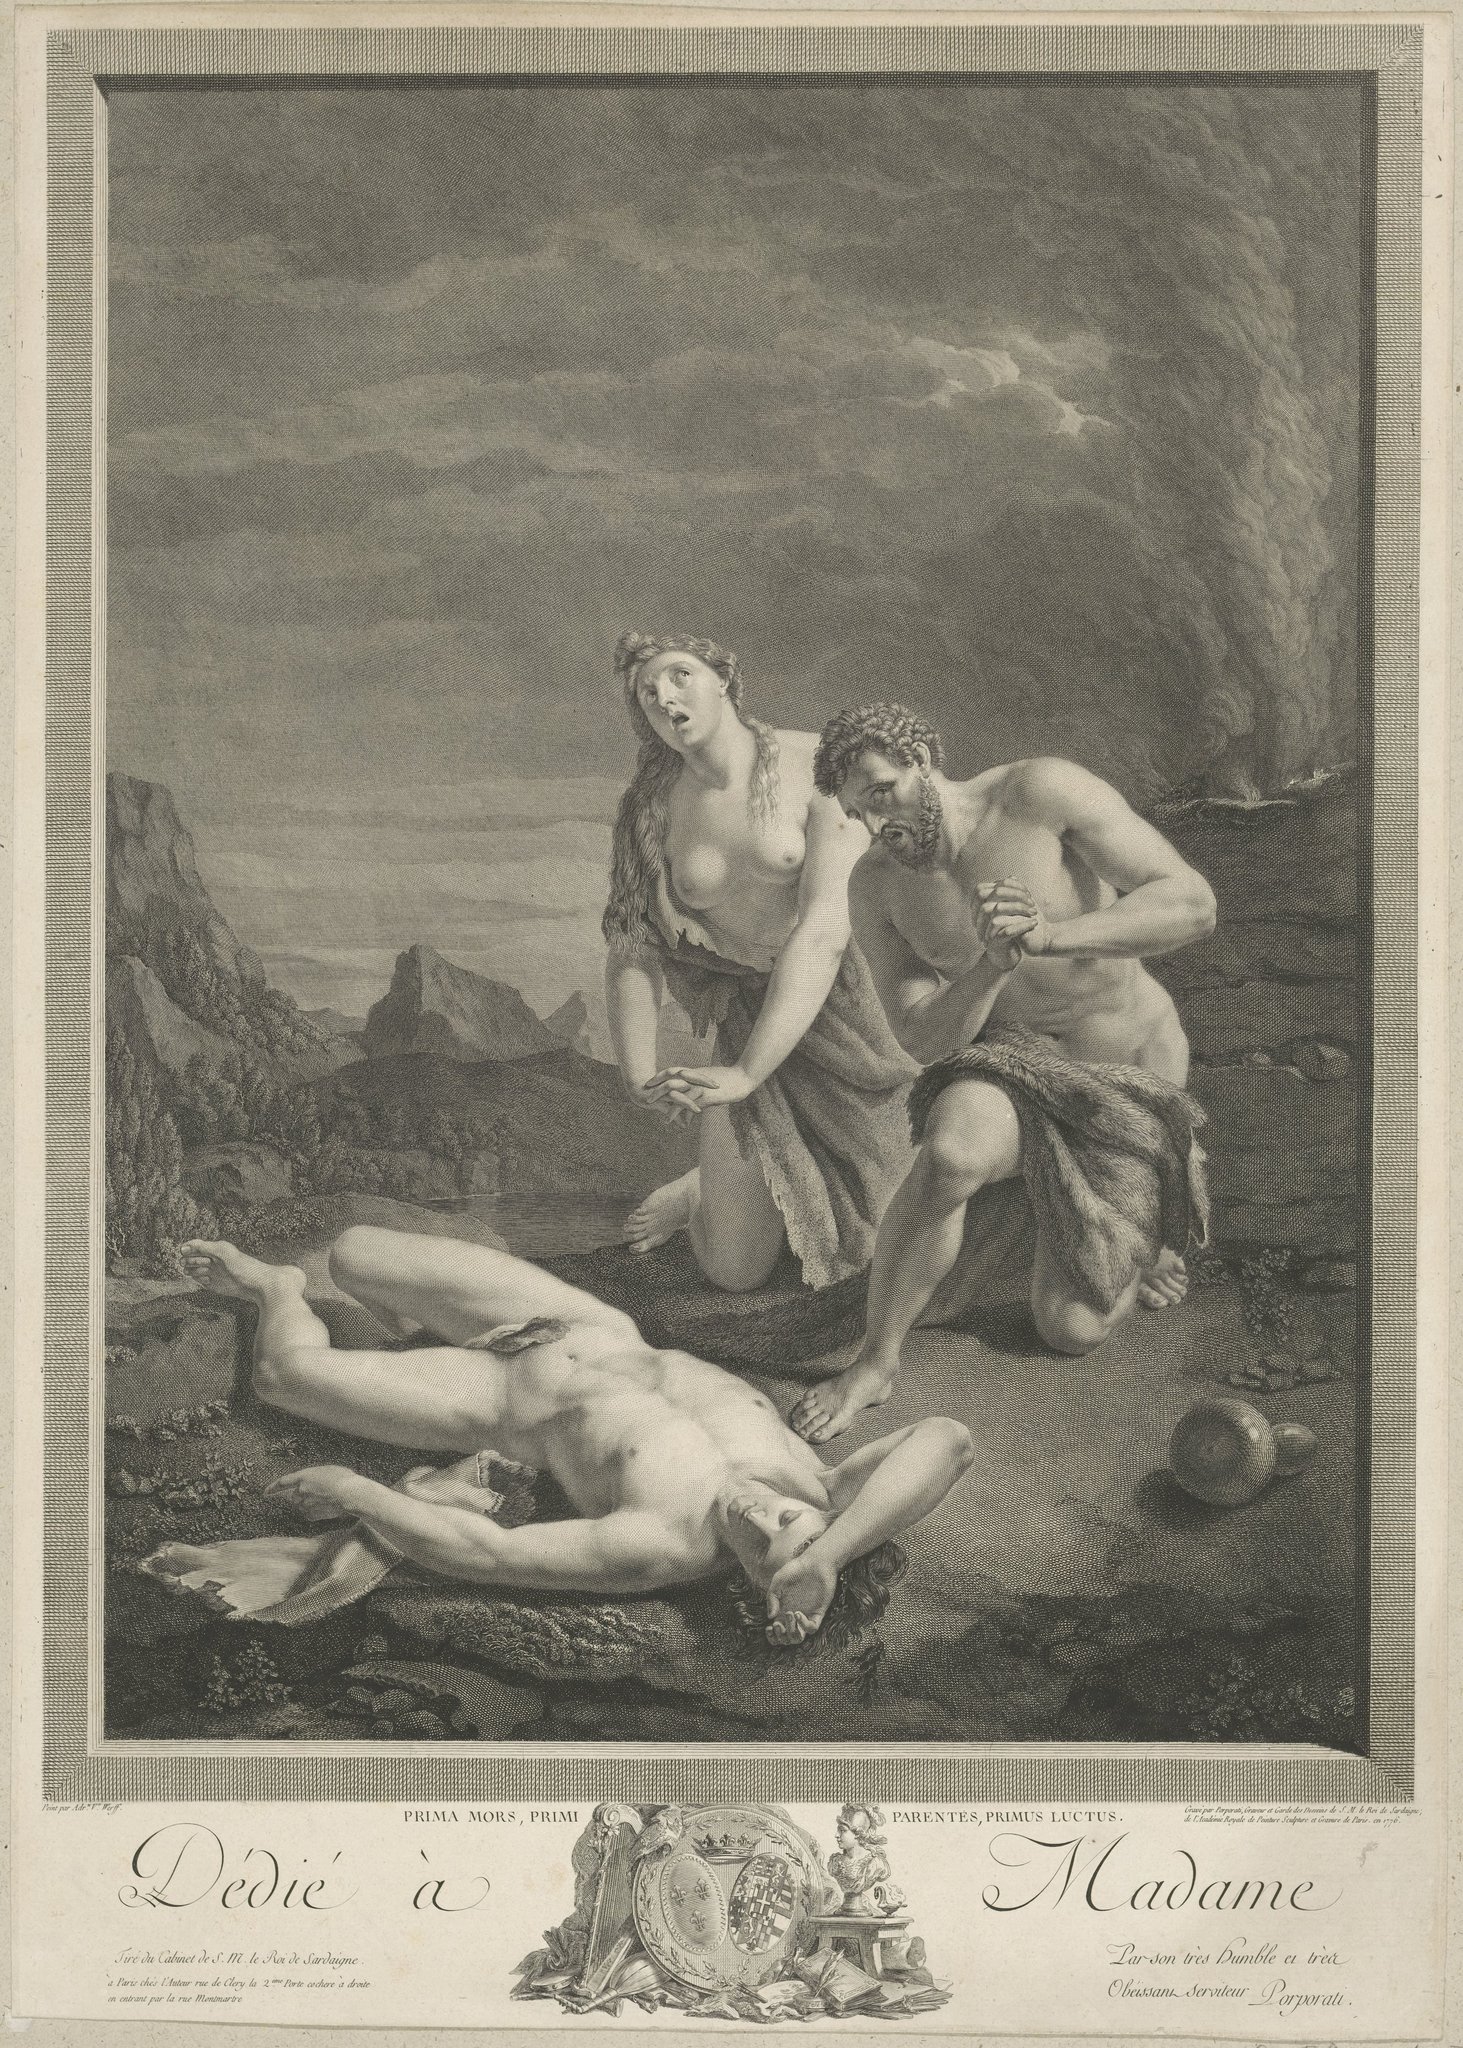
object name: print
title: Adam en Eva bij het lijk van Abel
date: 1776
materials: paper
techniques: engraving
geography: italy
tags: adam and eve discover the dead body of abel and grieve over it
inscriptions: collector's mark: Lugt 2165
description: Adam en Eva ontdekken het dode lichaam van Abel en treuren.